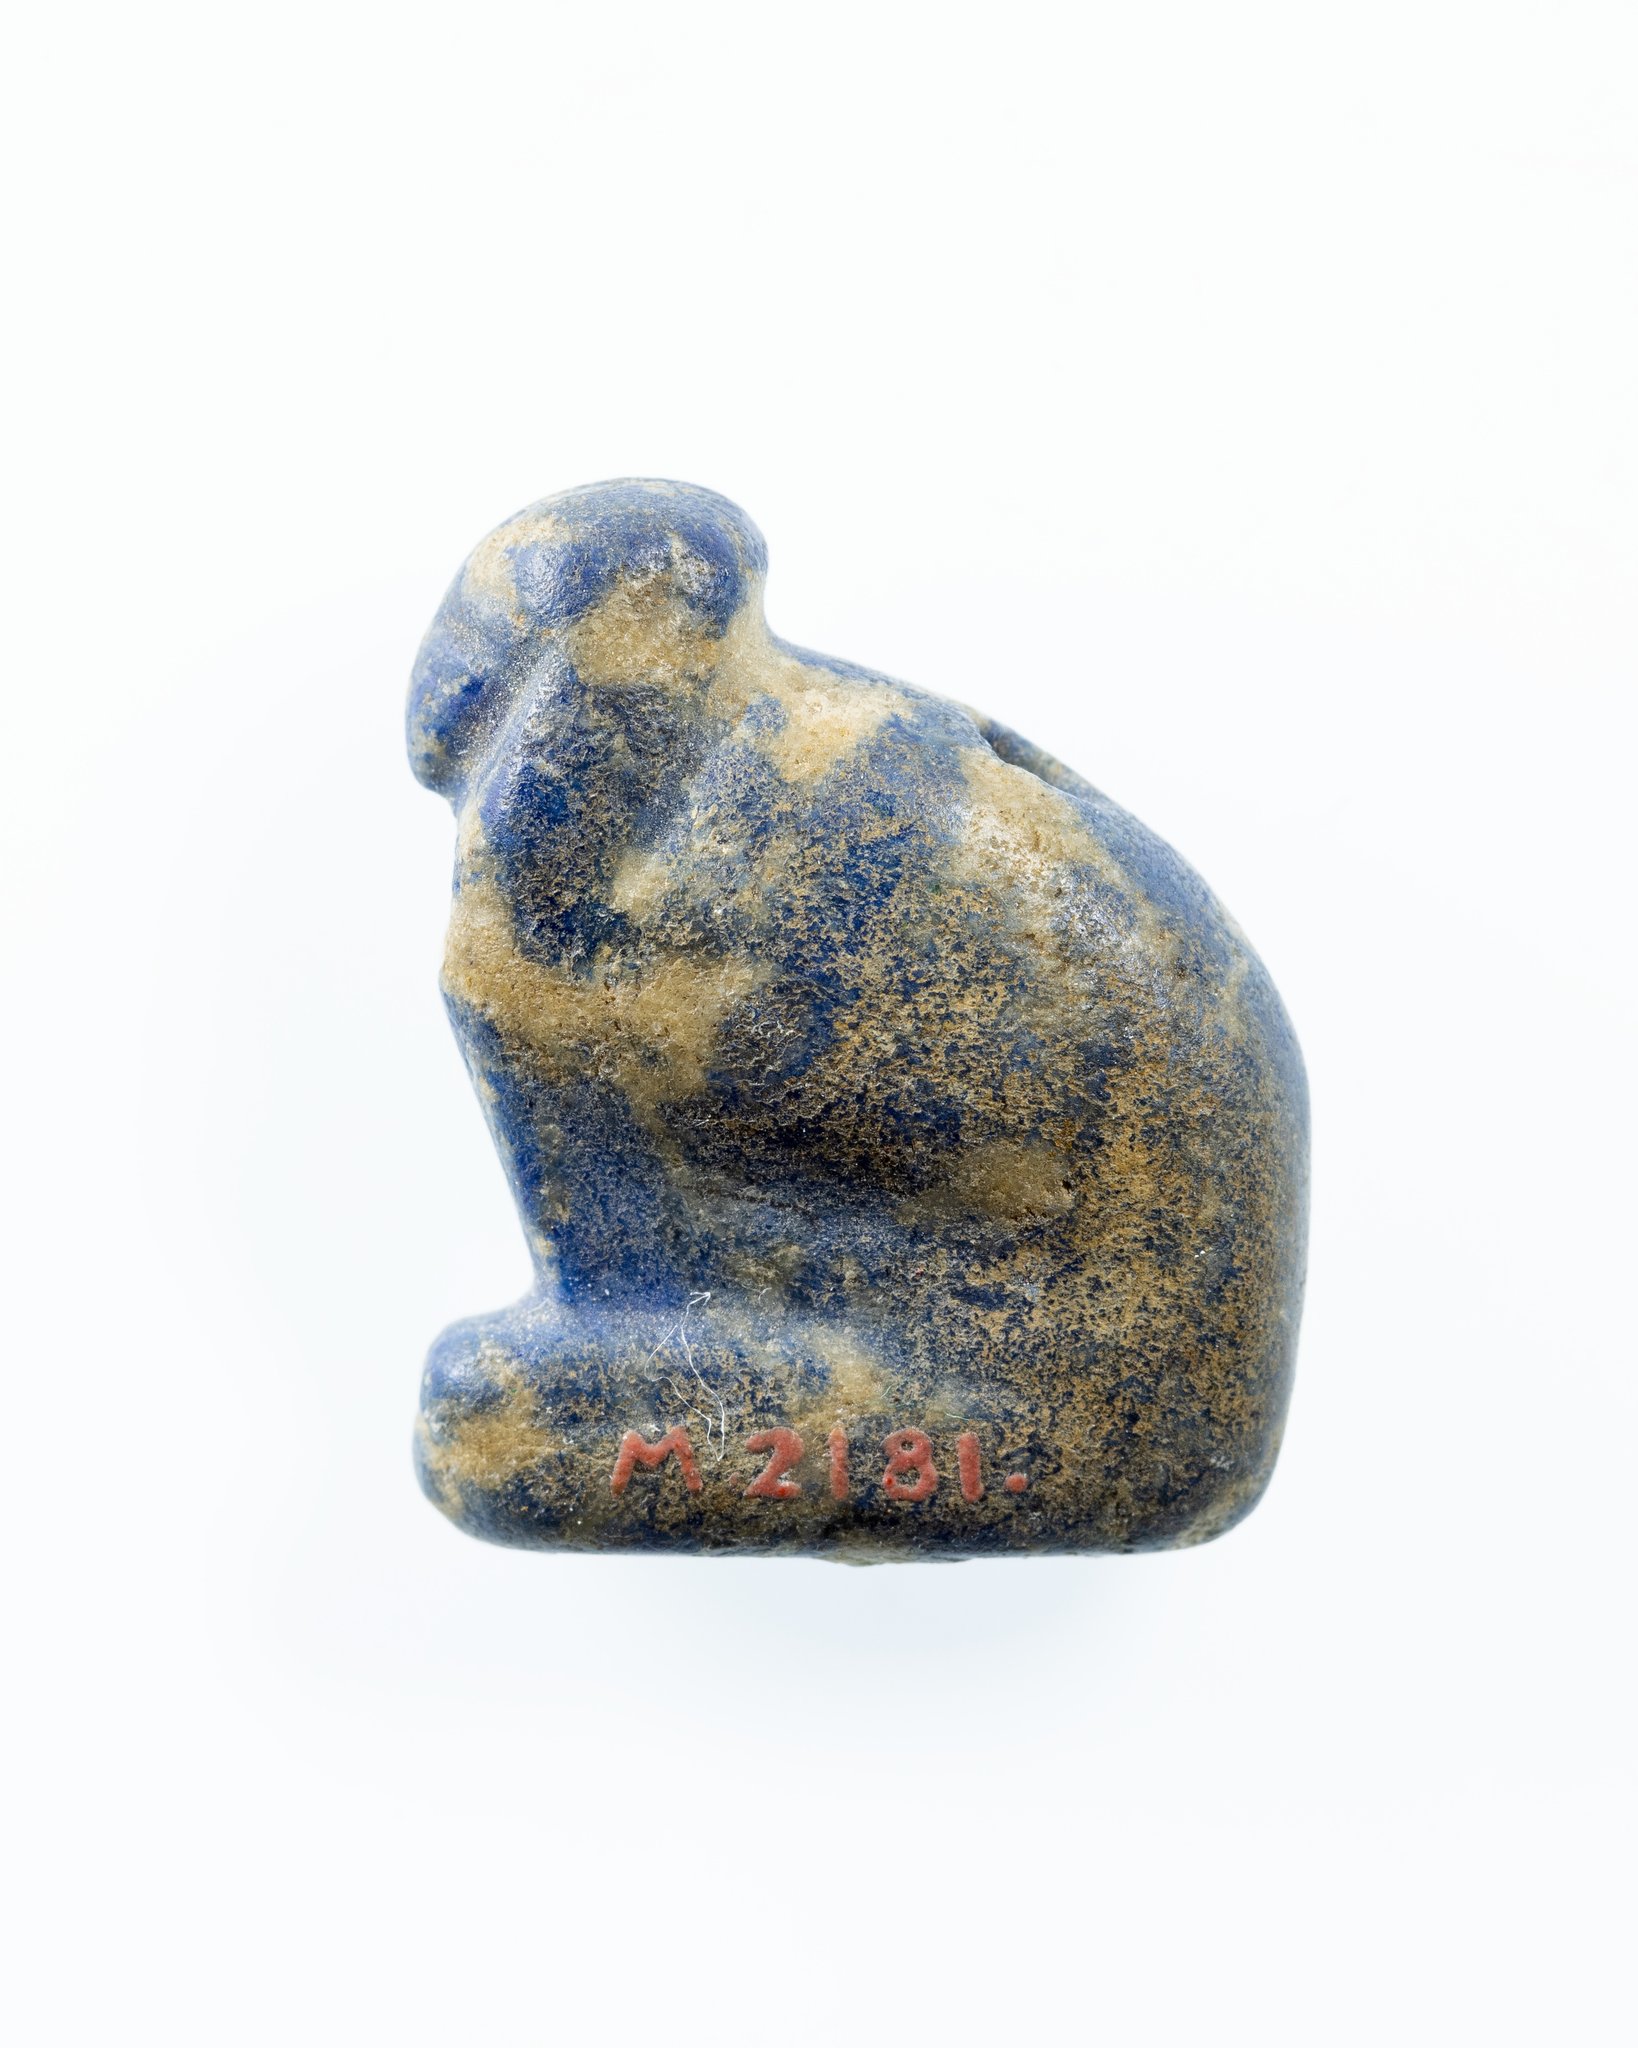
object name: female sphinx amulet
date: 1981-1550 BCE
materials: lapis lazuli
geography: egypt